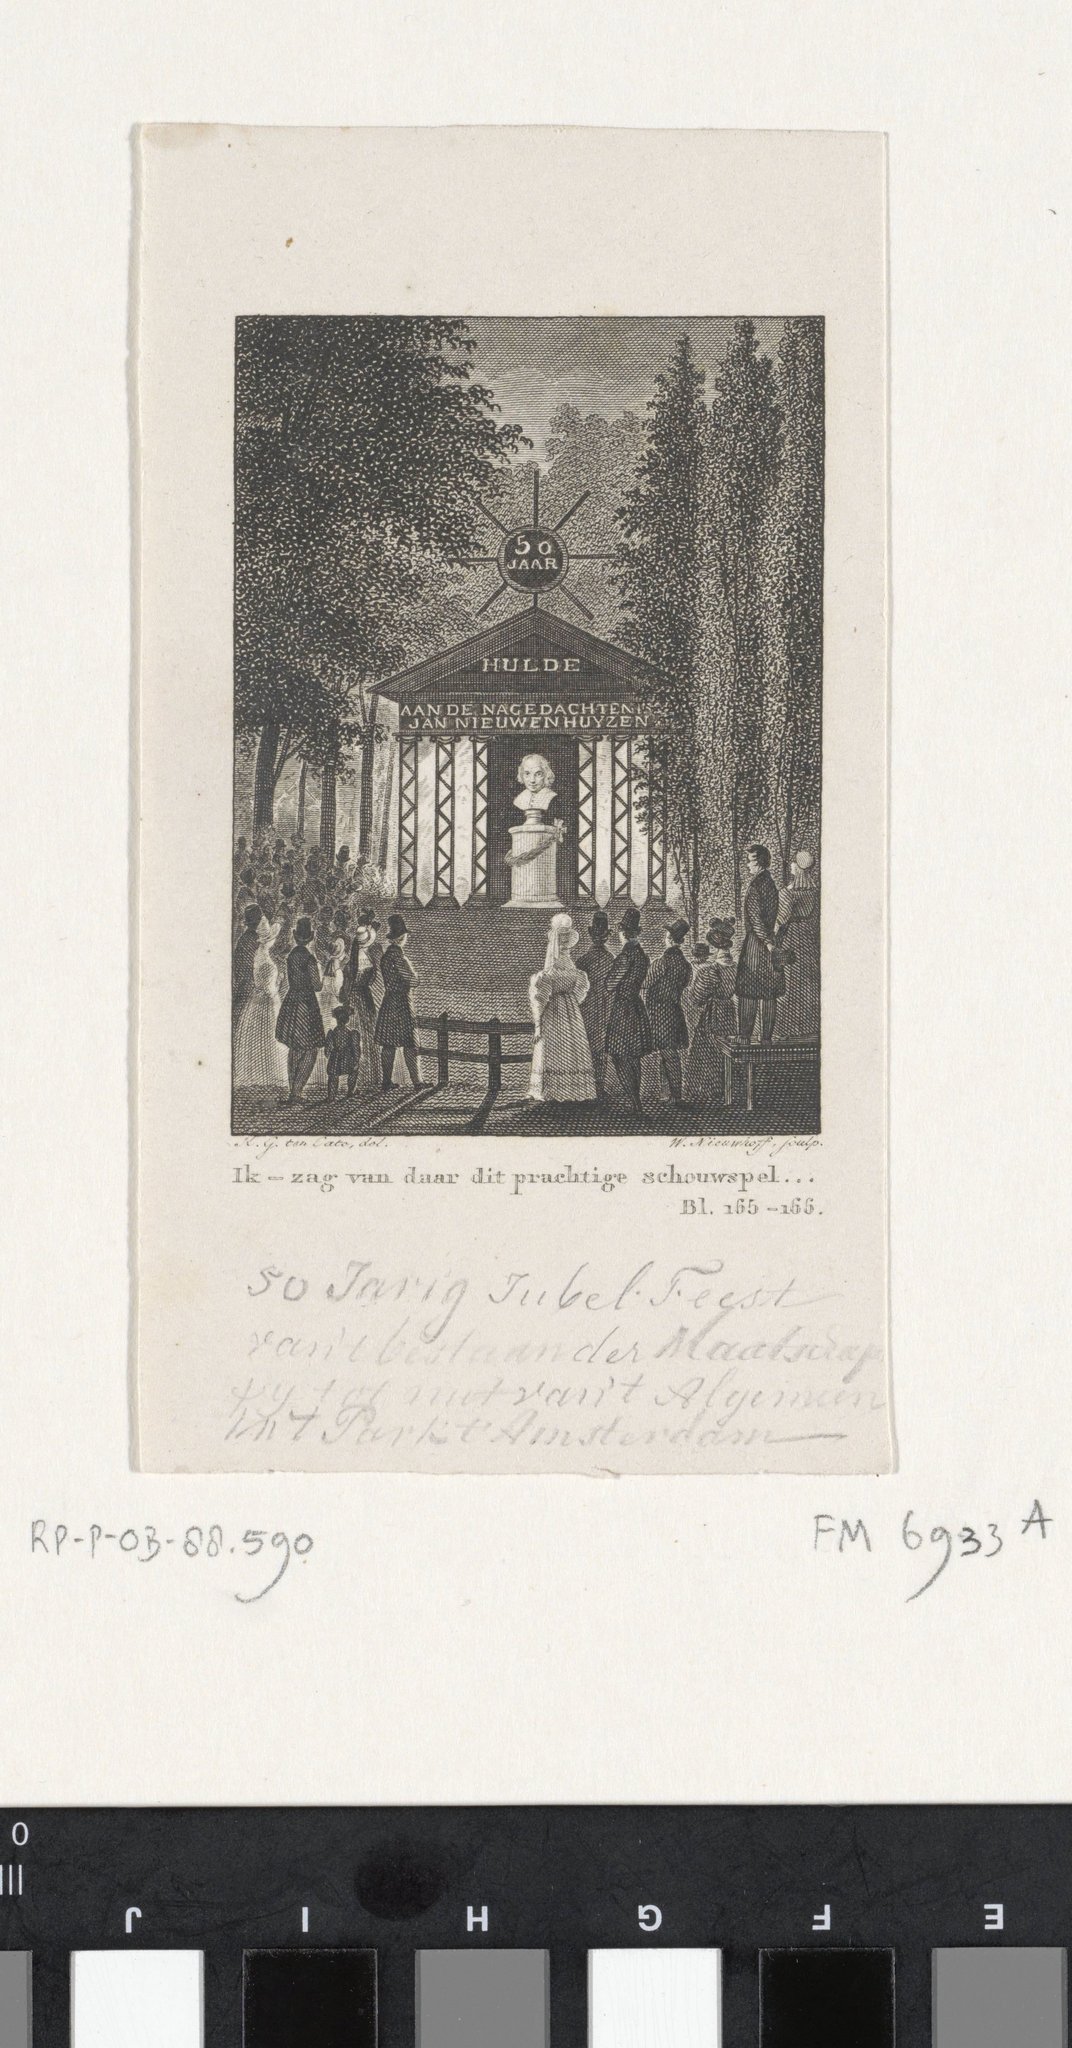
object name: print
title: Viering van het vijftigjarige bestaan van de Maatschappij tot Nut van 't Algemeen, 1834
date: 1834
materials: paper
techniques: engraving, etching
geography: amsterdam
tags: haarlem, jan nieuwenhuyzen, public festivities (+ illumination, fire-works ~ festive activities)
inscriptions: collector's mark: Lugt 2228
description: Buste van Jan Nieuwenhuyzen in een verlicht tempeltje bewonderd door een groep mensen. Avondfeest in de Amsterdamse Plantage ter gelegenheid van het vijftigjarige bestaan van de Maatschappij tot Nut van 't Algemeen, 16 november 1834